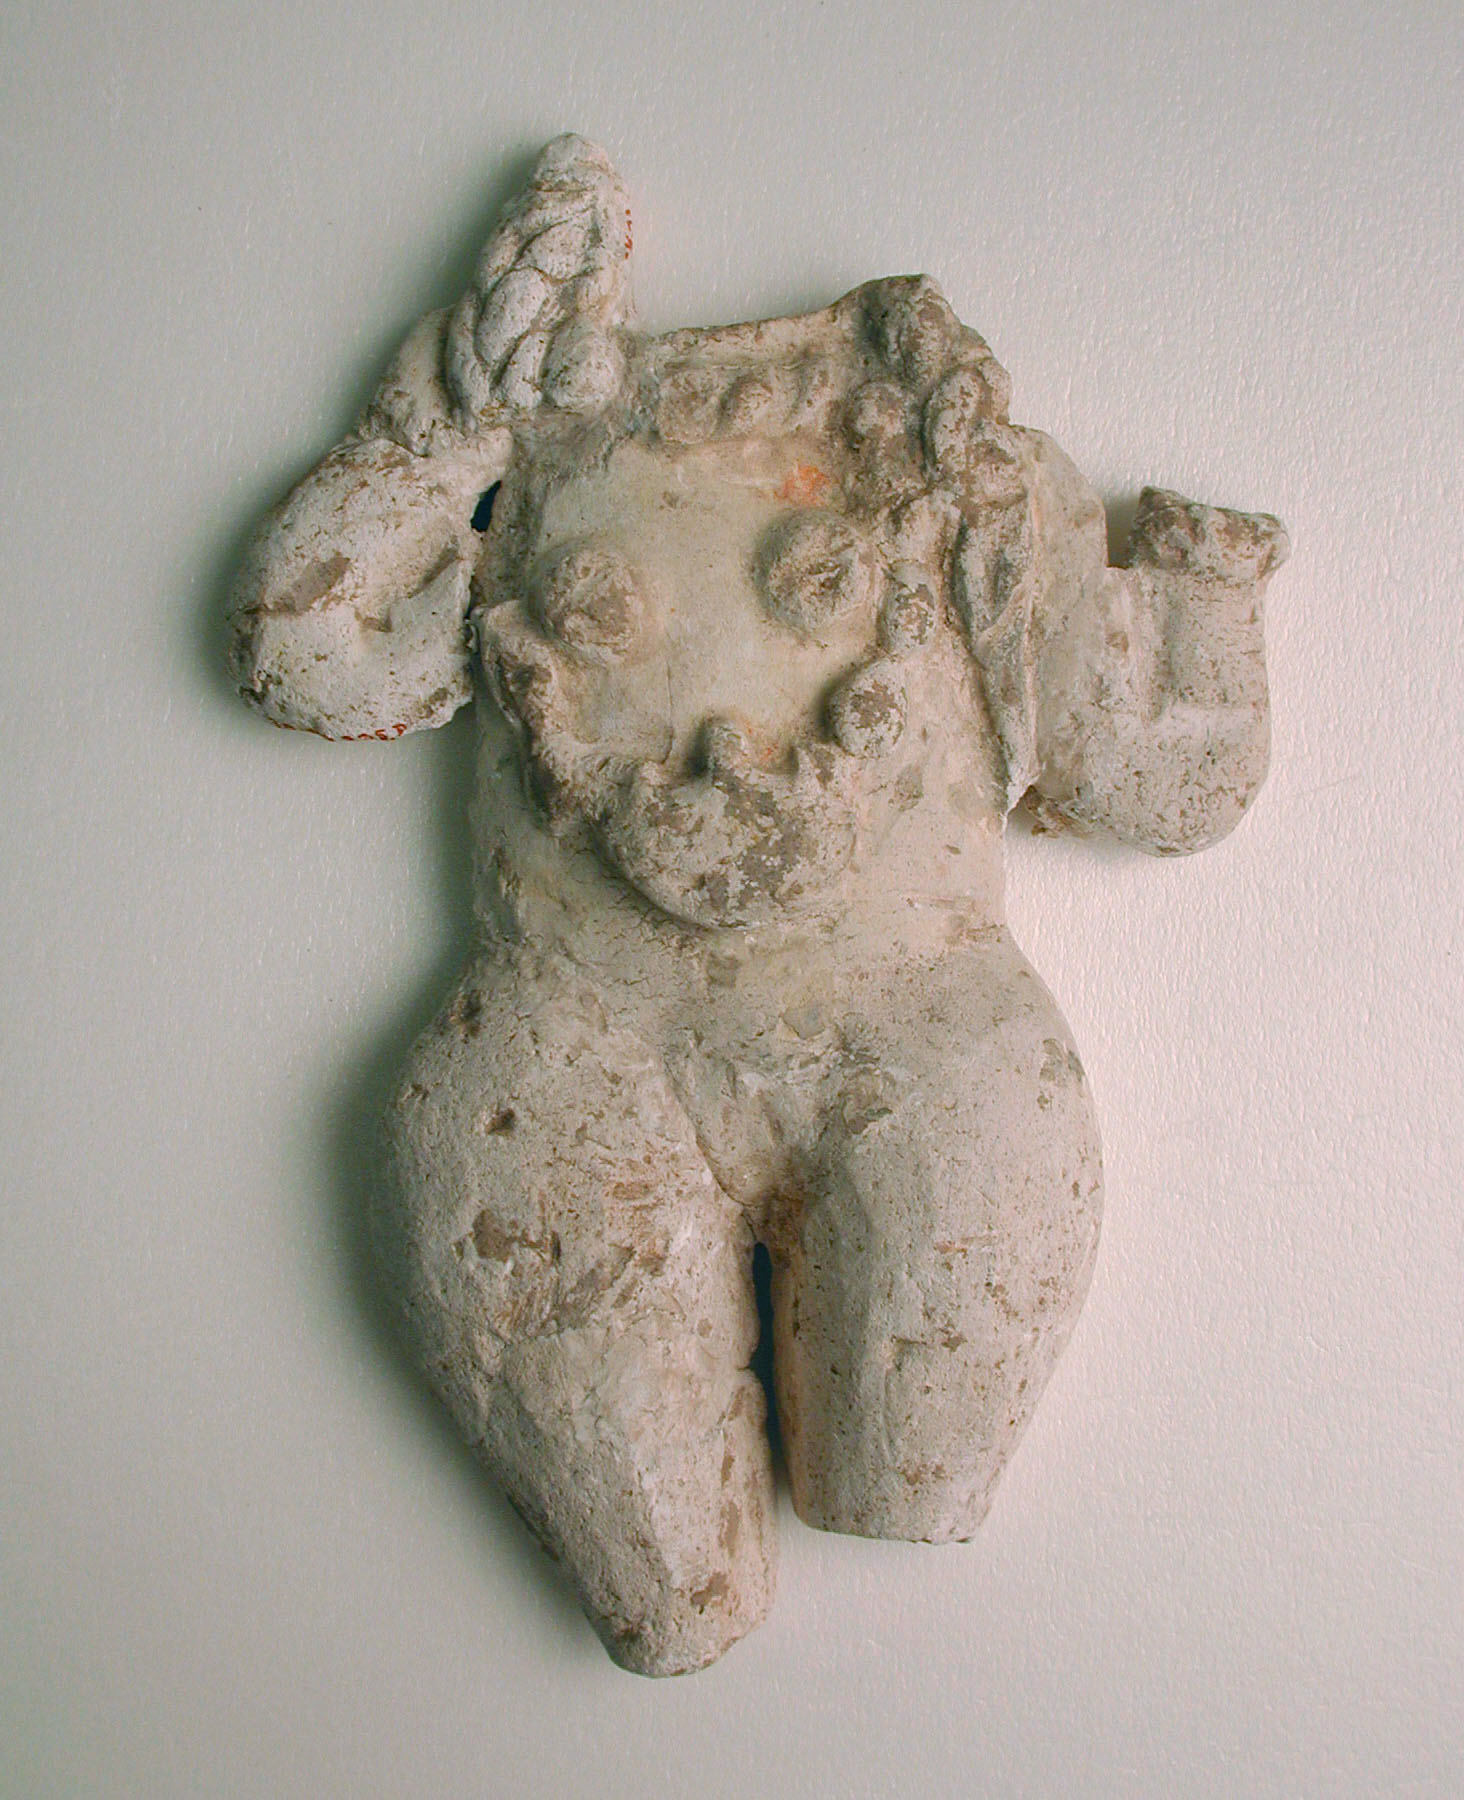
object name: figure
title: Naked Female Figure with Necklace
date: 801-1000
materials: plaster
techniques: painting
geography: iran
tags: female nudes